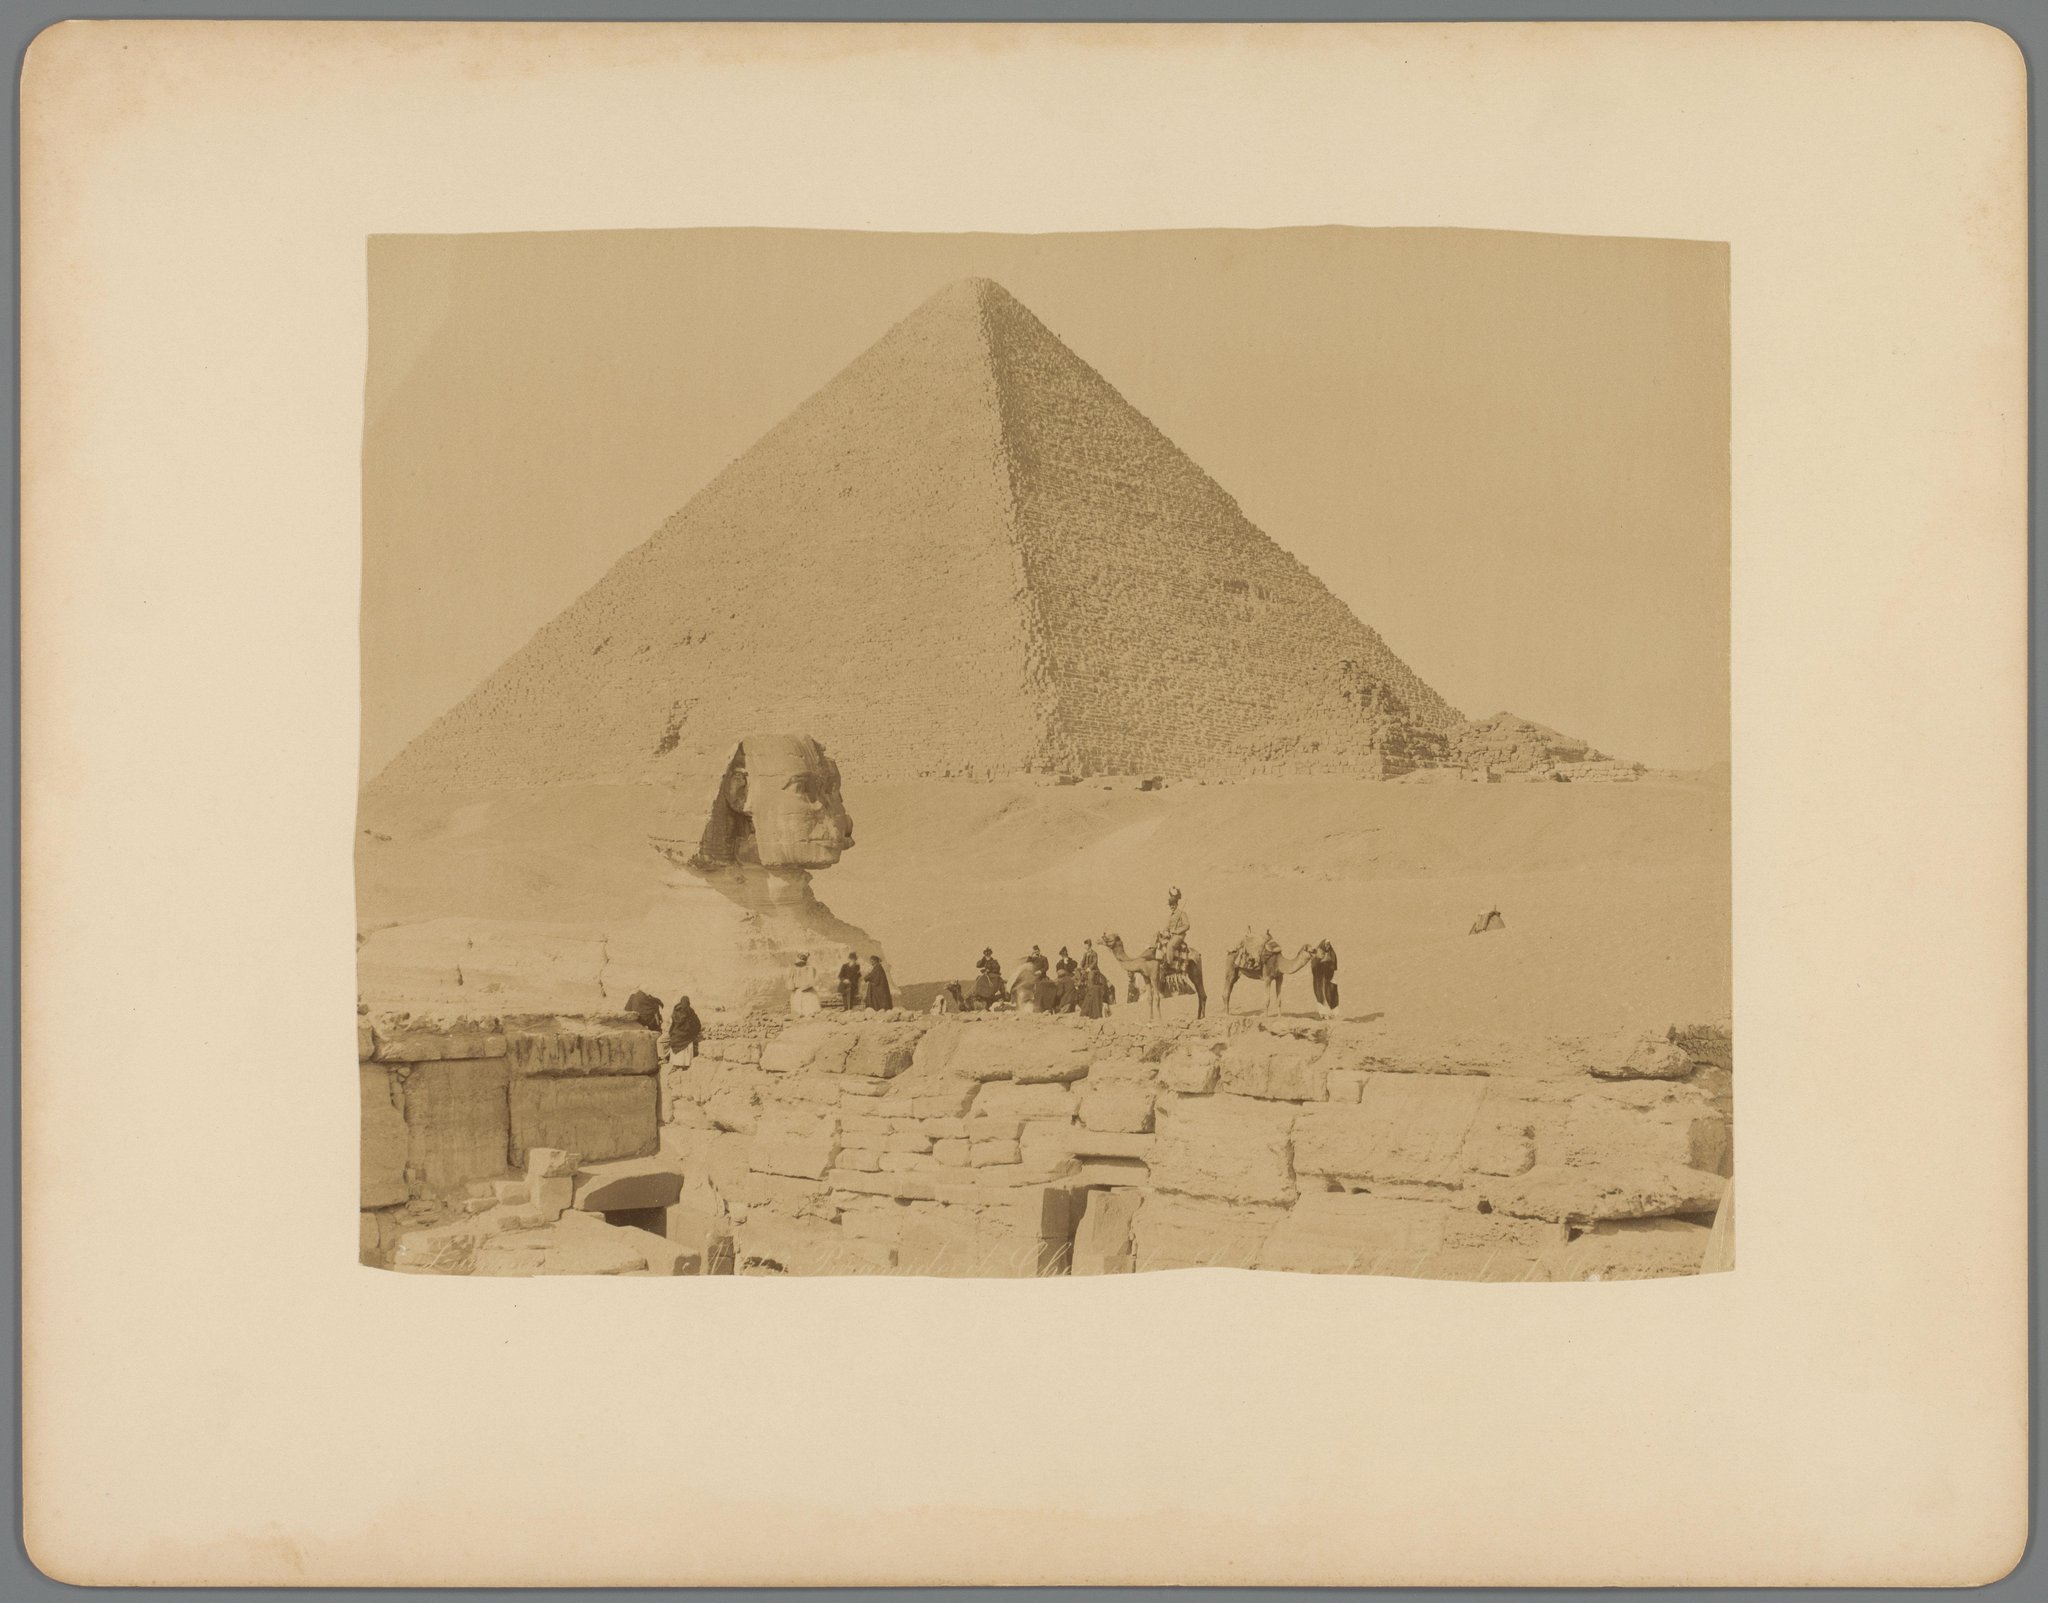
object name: photograph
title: Reizigers voor de sfinx en de piramide van Cheops, Gizeh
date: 1870-1895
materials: cardboard, paper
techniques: albumen print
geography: gizeh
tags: sphinx (lion/woman); 'sfinge' (ripa), egyptian pyramids (wonder of the world)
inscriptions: inscription: ‘N 443. Pyramide de Cheops [...]’, inscription: ‘Foto’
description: Deze foto zat oorspronkelijk in prentenkabinet RP-F-AA3192.